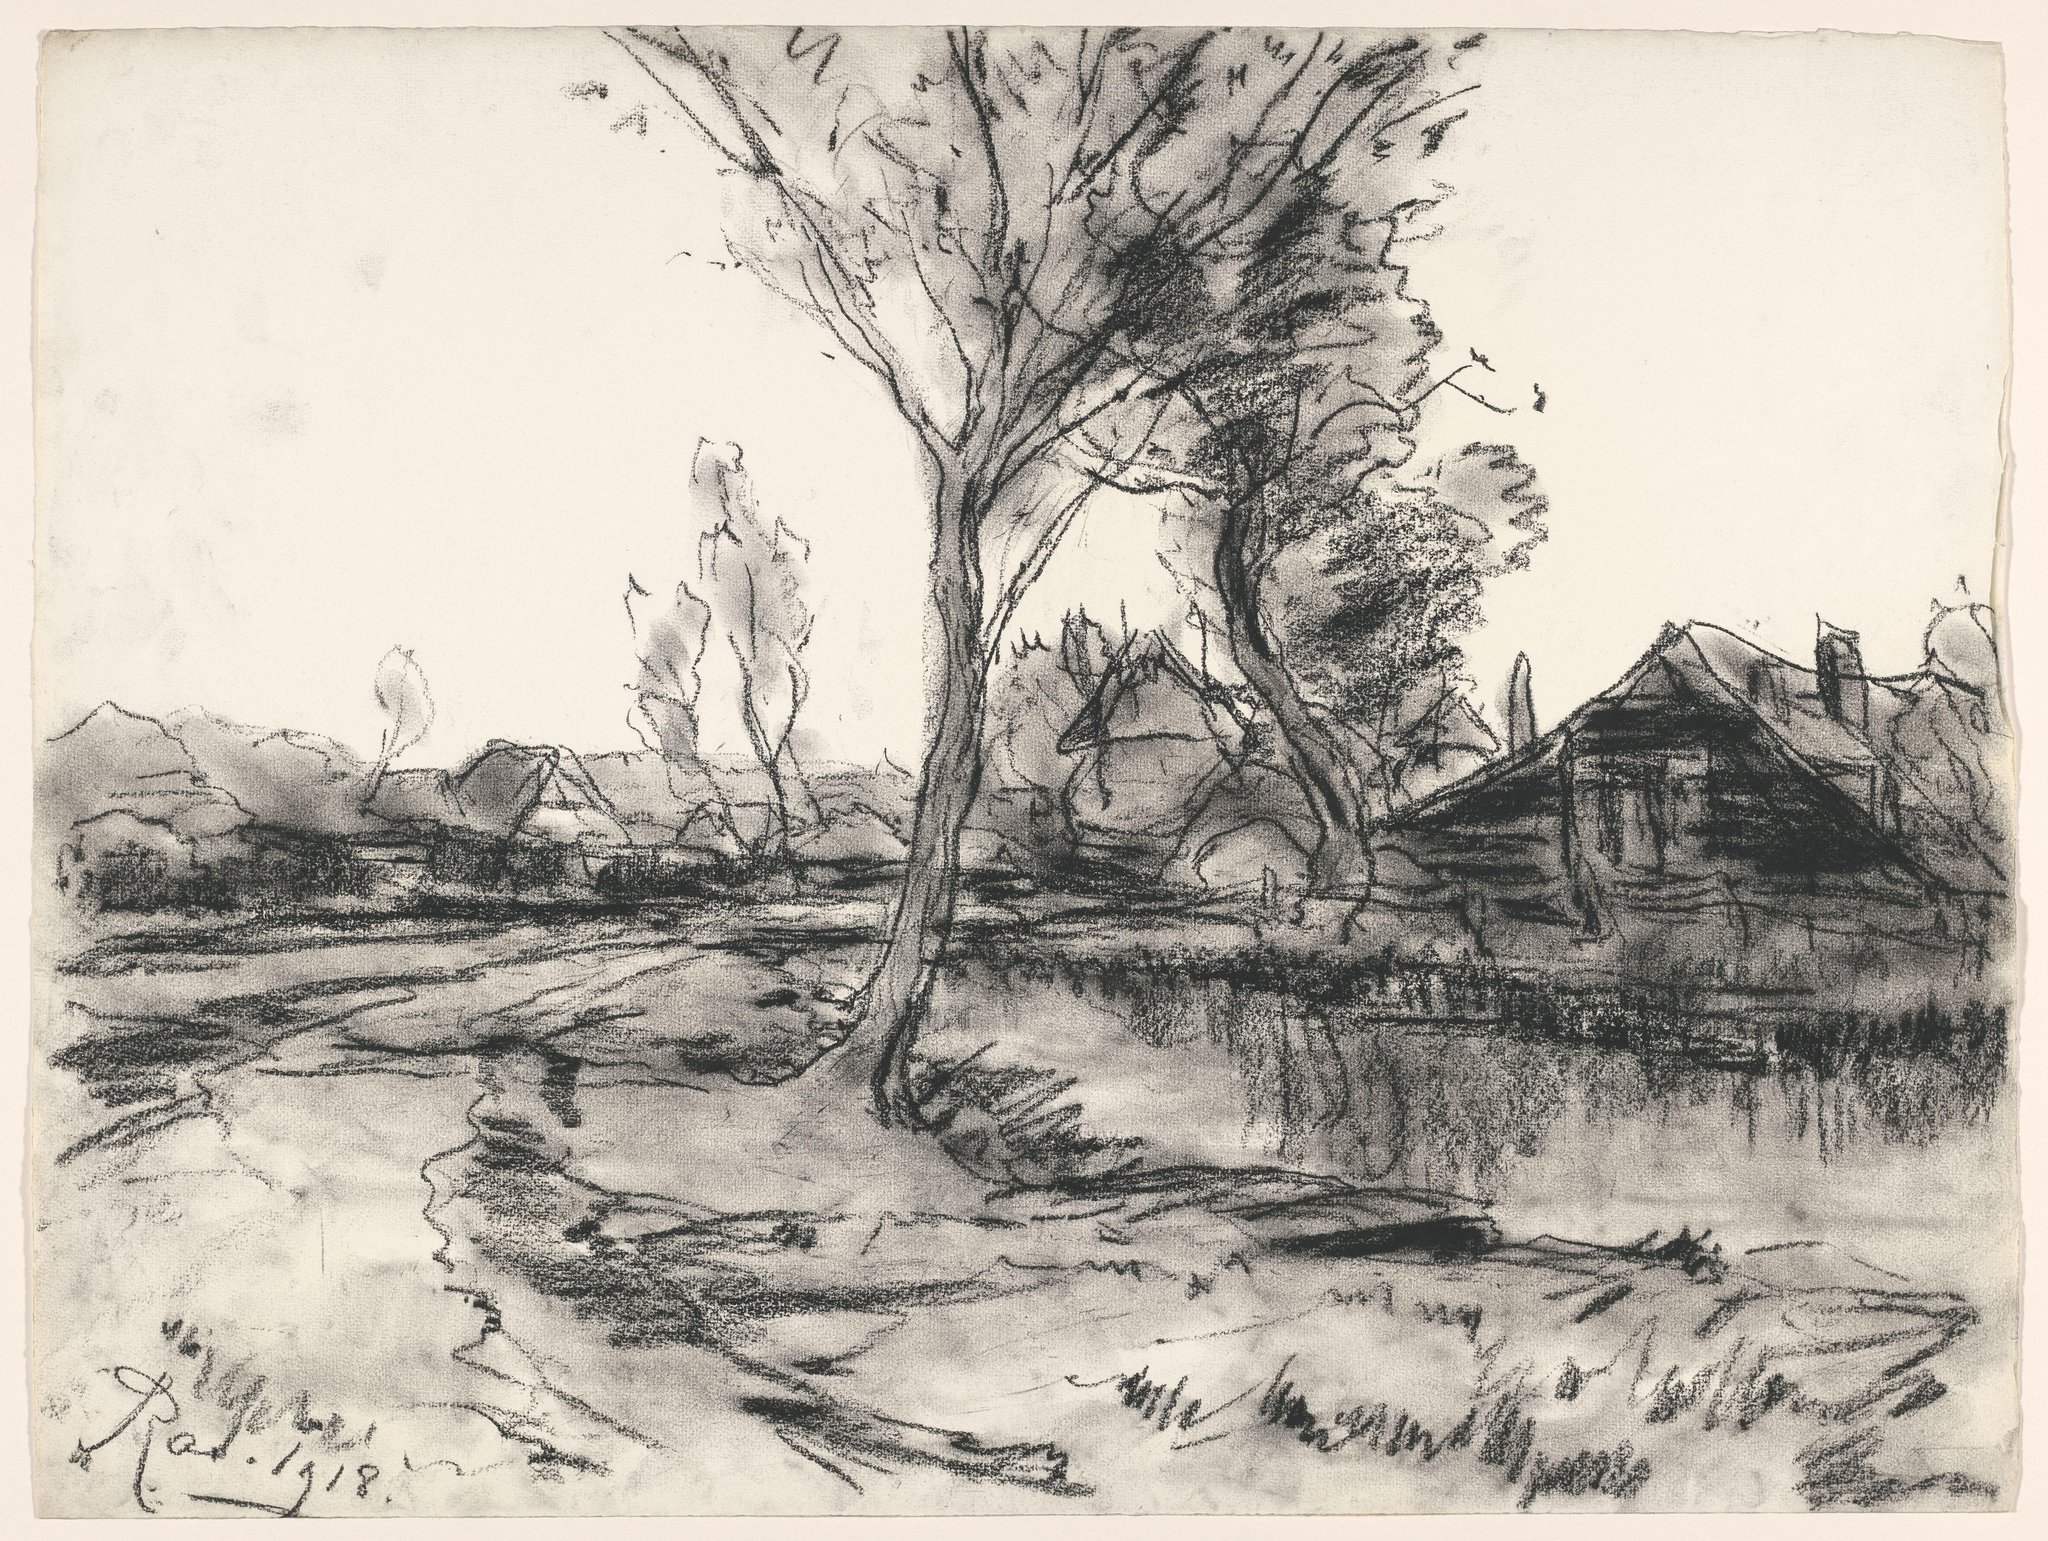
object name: drawing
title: Huizen aan een weg langs water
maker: pieter h.j.j. ras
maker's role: draughtsman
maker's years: 1857-1941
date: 1918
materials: chalk, paper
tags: river, country-house